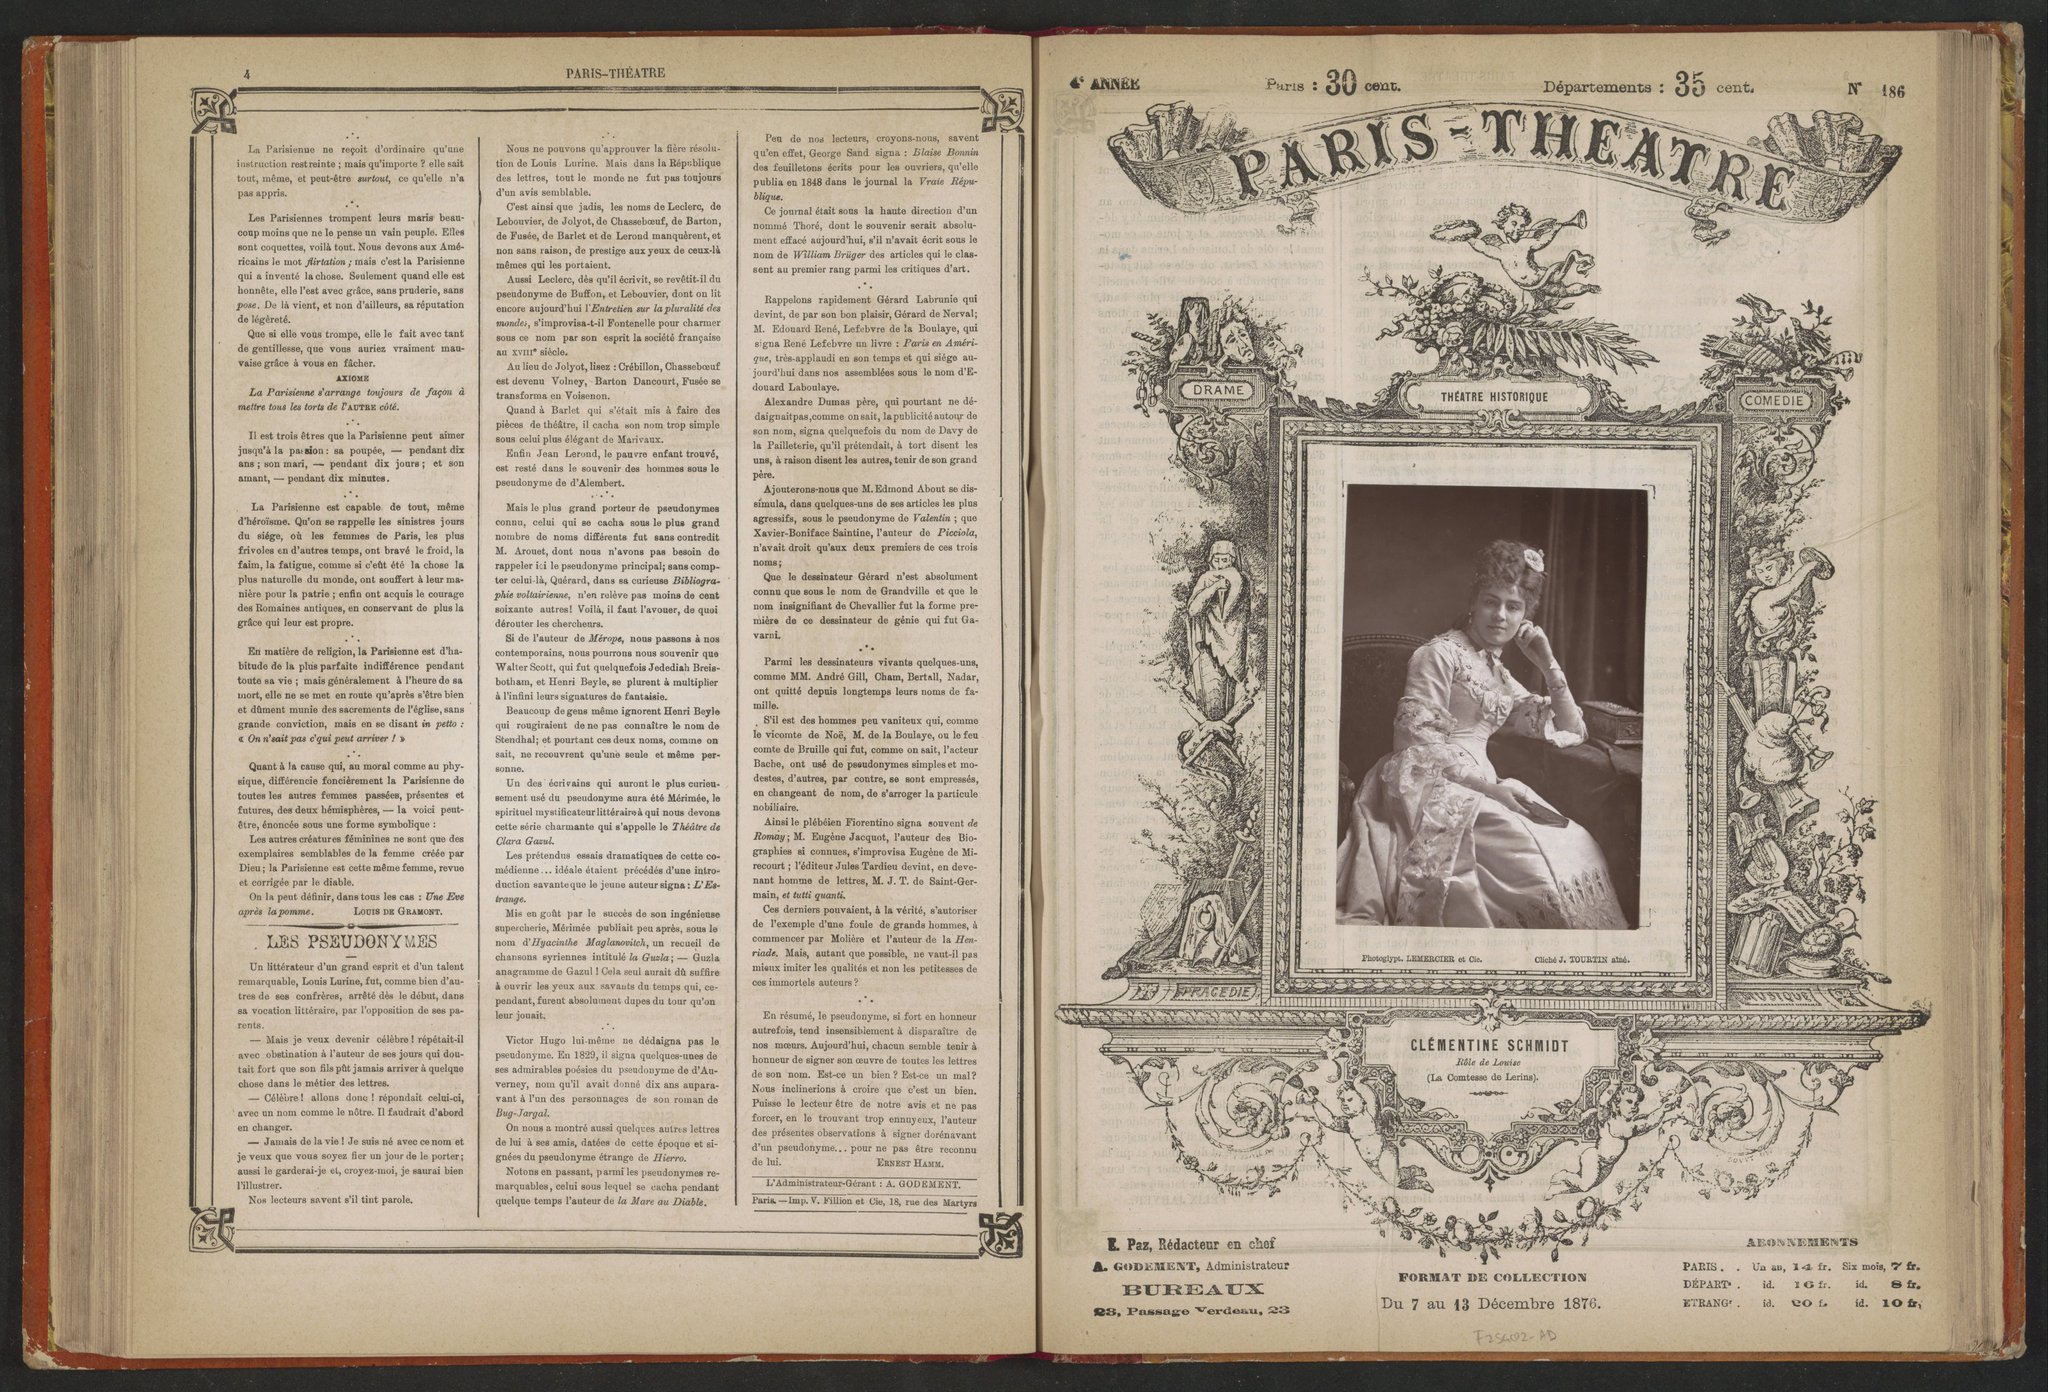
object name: page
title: Clémentine Schmidt Rôle de Louise (La Comtesse de Lerins)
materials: paper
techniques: woodburytype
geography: paris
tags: portrait of actor, actress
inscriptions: inscription: ‘Du 7 au 13 Décembre 1876.’, number: ‘N' 186’